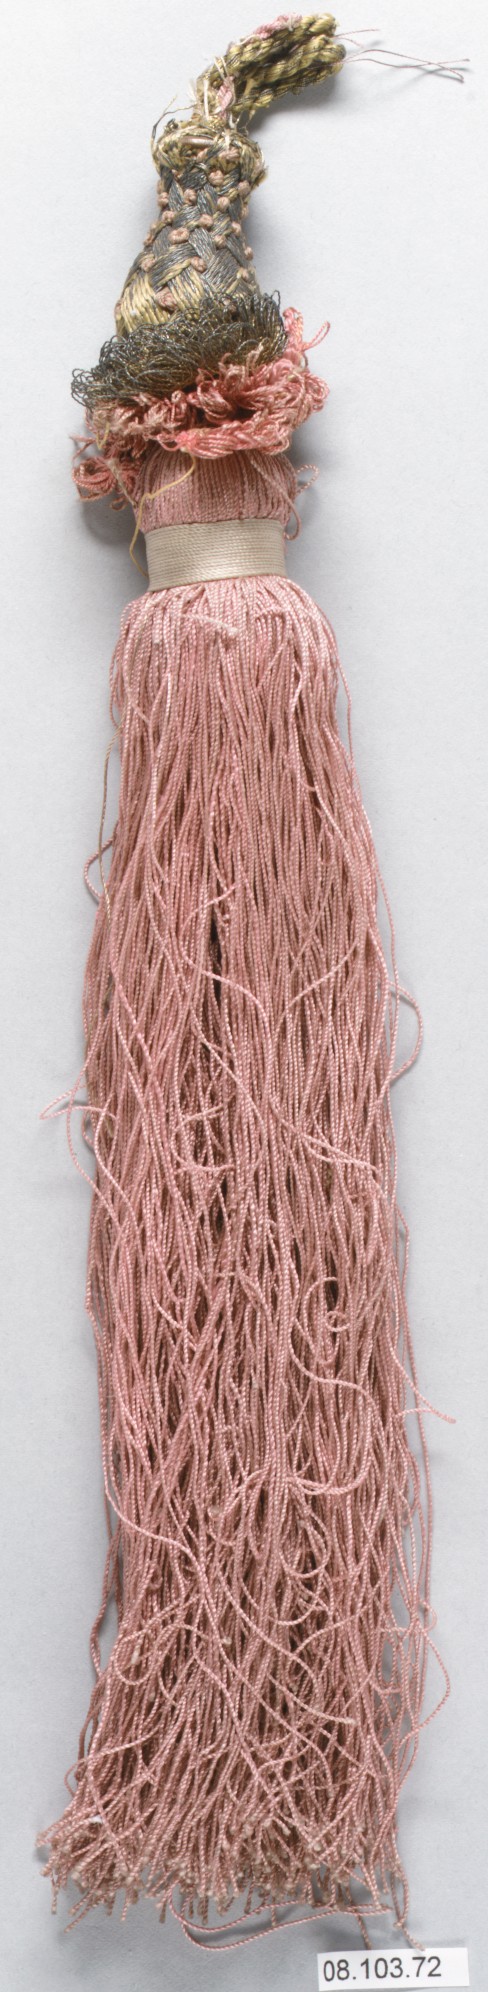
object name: tassel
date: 1801-1900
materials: silk